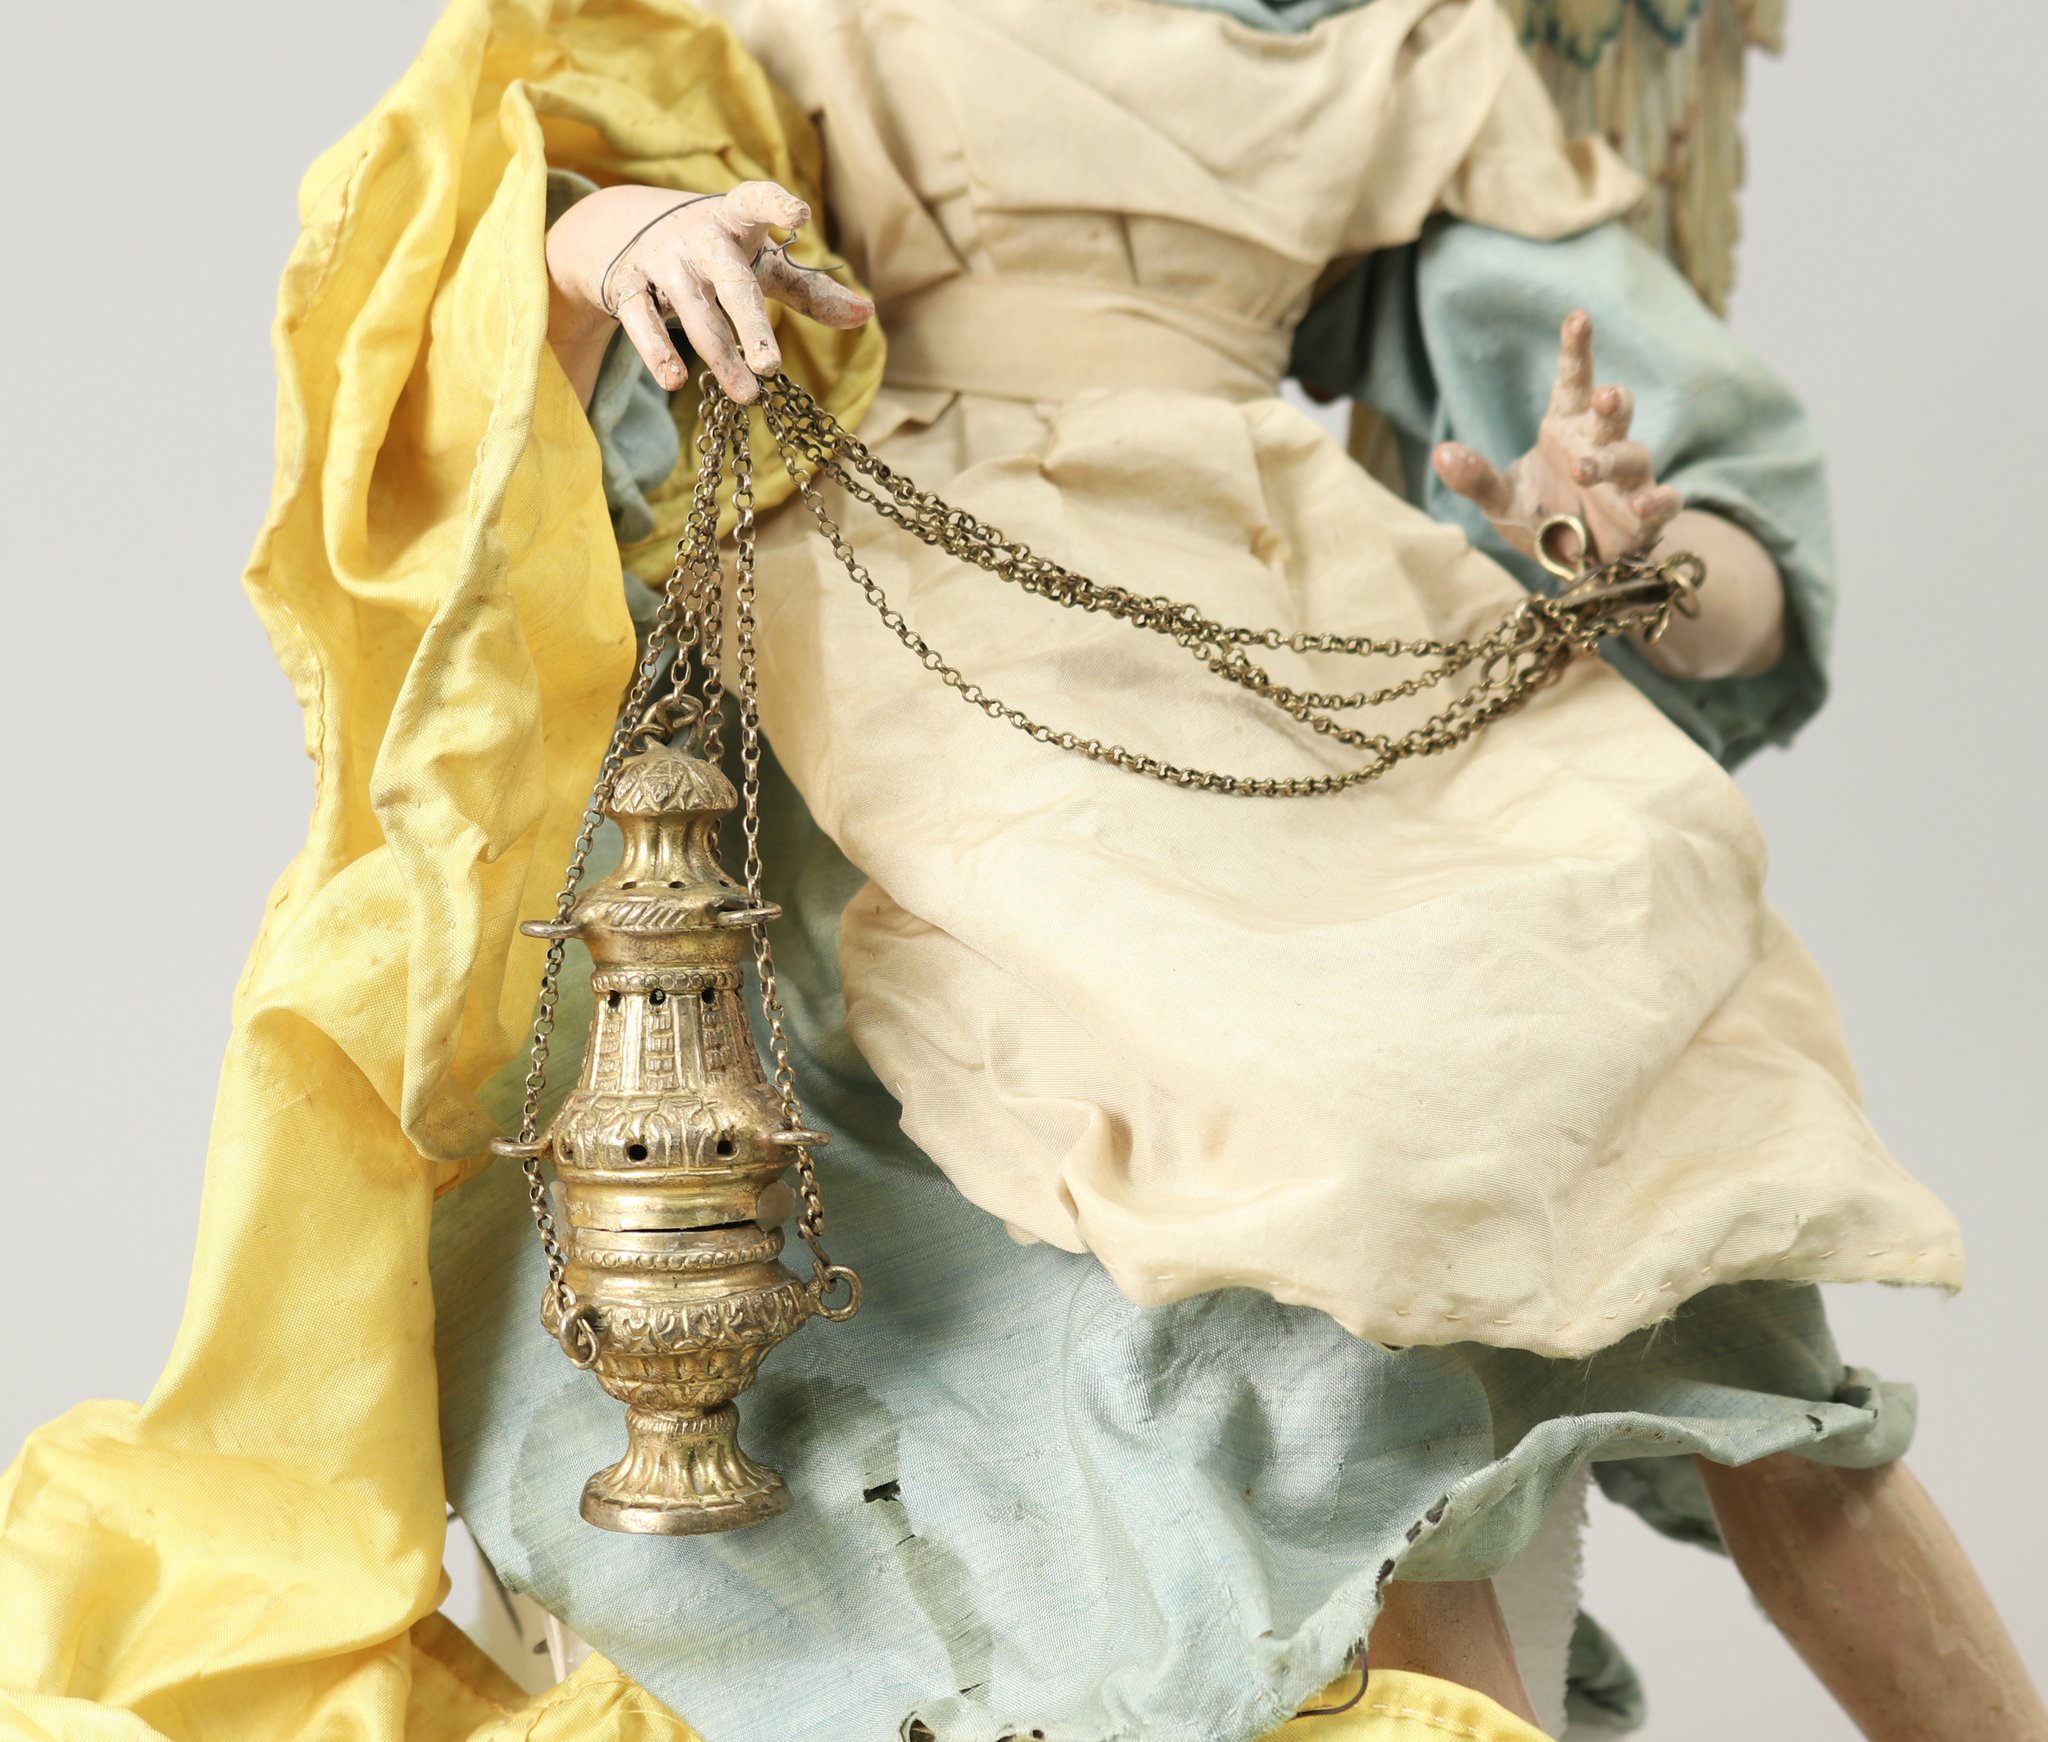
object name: crèche figure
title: Censer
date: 1751-1800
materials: silver gilt